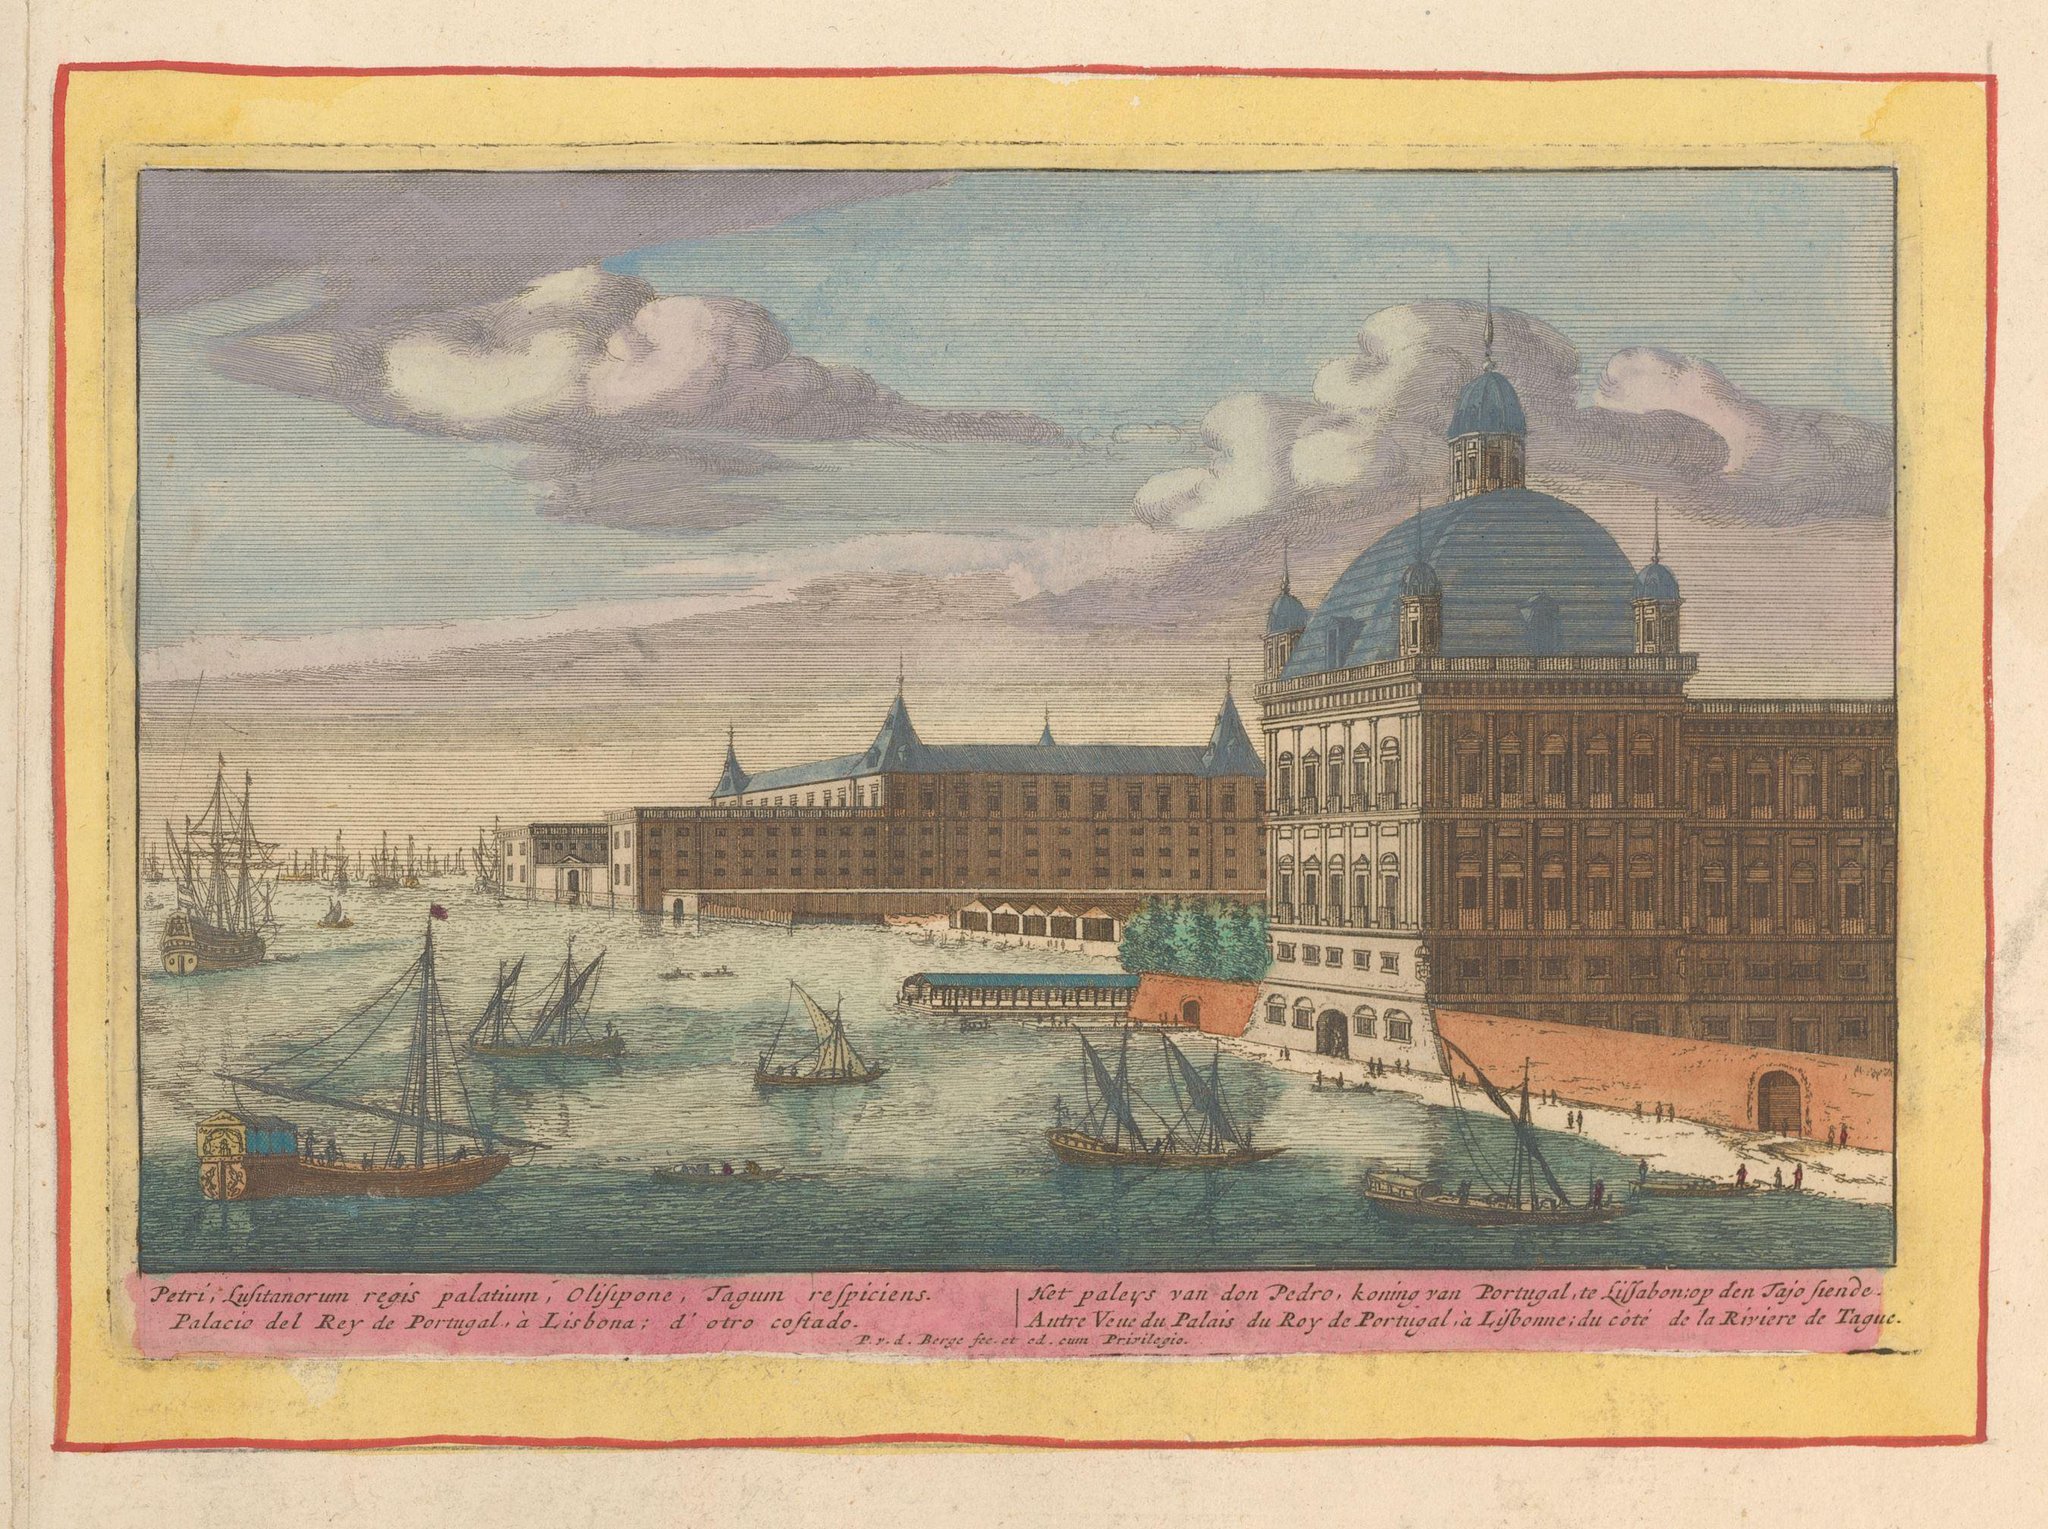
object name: print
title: Theatrum Hispaniae (...)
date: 1694-1737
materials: paper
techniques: etching, hand coloring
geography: the hague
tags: palace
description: Gezicht op het Koninklijk Paleis te Lissabon vanuit de rivier de Taag gezien. Op de rivier varen zeilschepen. Onder de voorstelling een titel in het Latijn, Spaans, Nederlands en Frans. Prent maakt deel uit van een album.